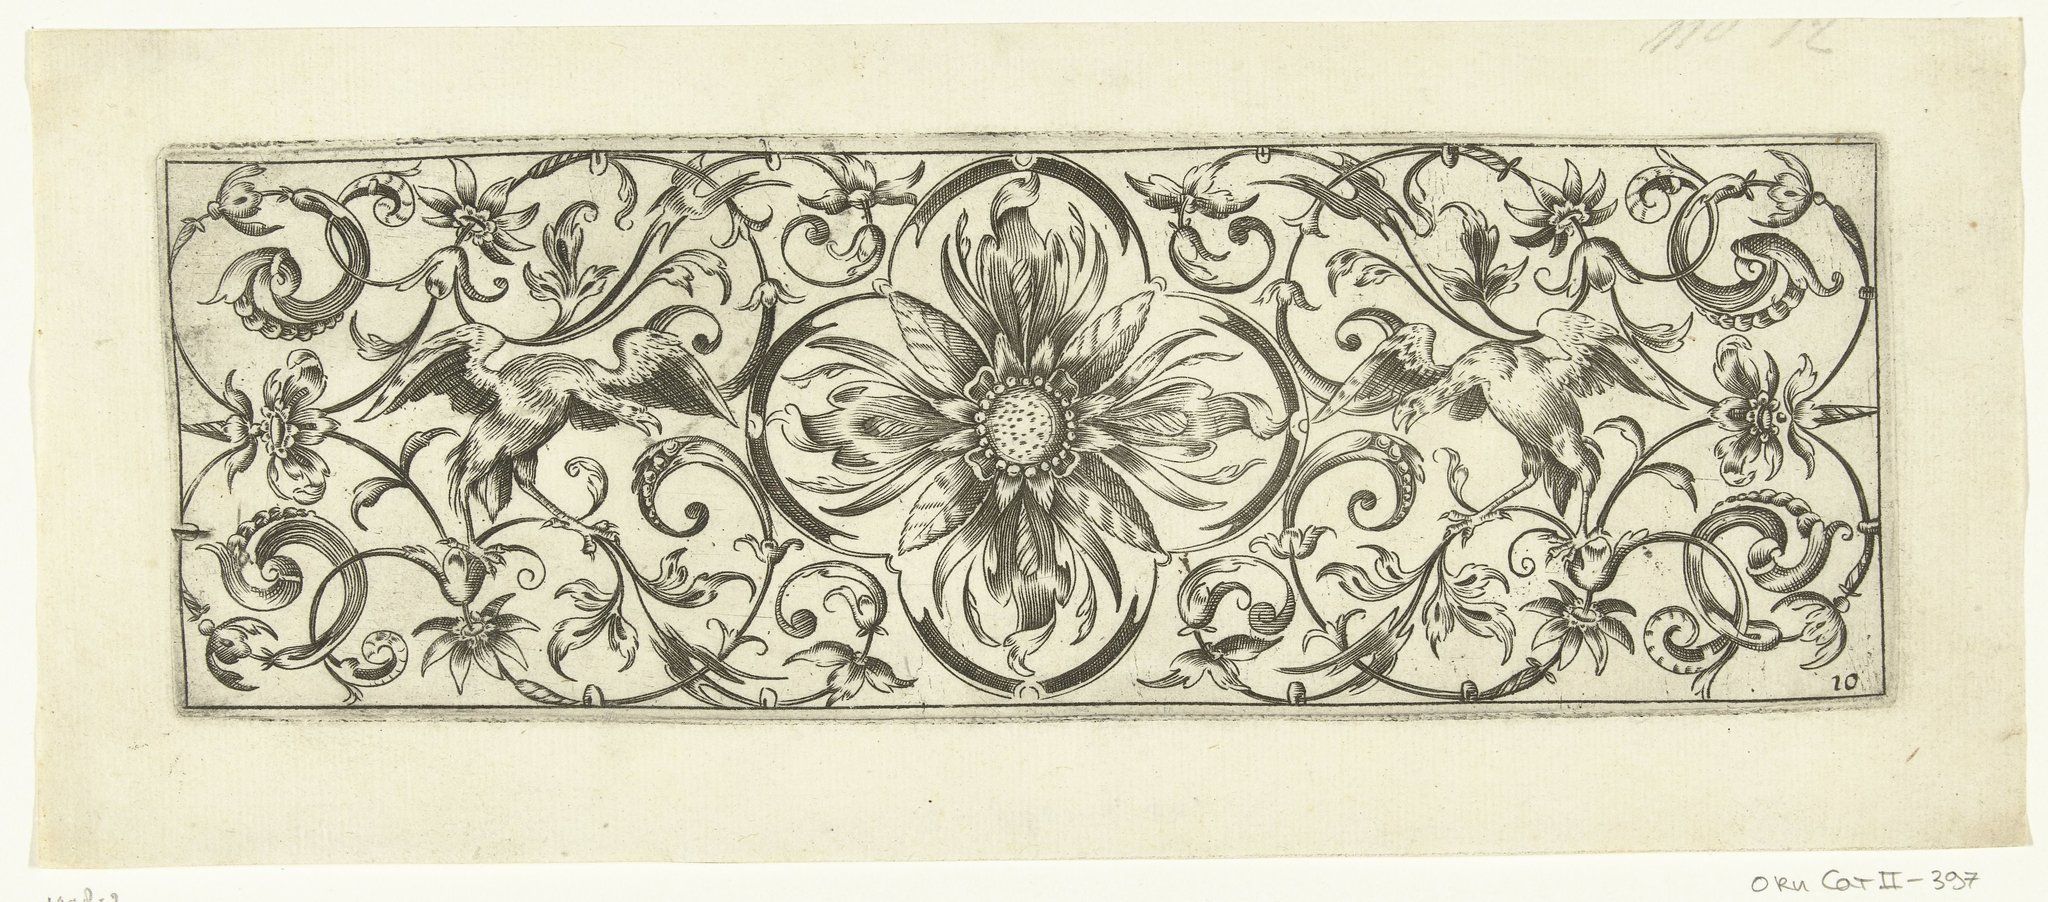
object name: print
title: Friezen met vogels en gestileerde bladranken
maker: claes jansz. visscher (ii)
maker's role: draughtsman, print maker, publisher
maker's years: 1586-1652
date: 1617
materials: paper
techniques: engraving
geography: amsterdam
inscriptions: inscription: ‘r.o.: 10’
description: In het midden een grote bloem, van boven af gezien, omgeven door bloemenranken en links en rechts een vogel. Blad 10 uit serie van 12 bladen met ontwerpen voor edelsmeden.